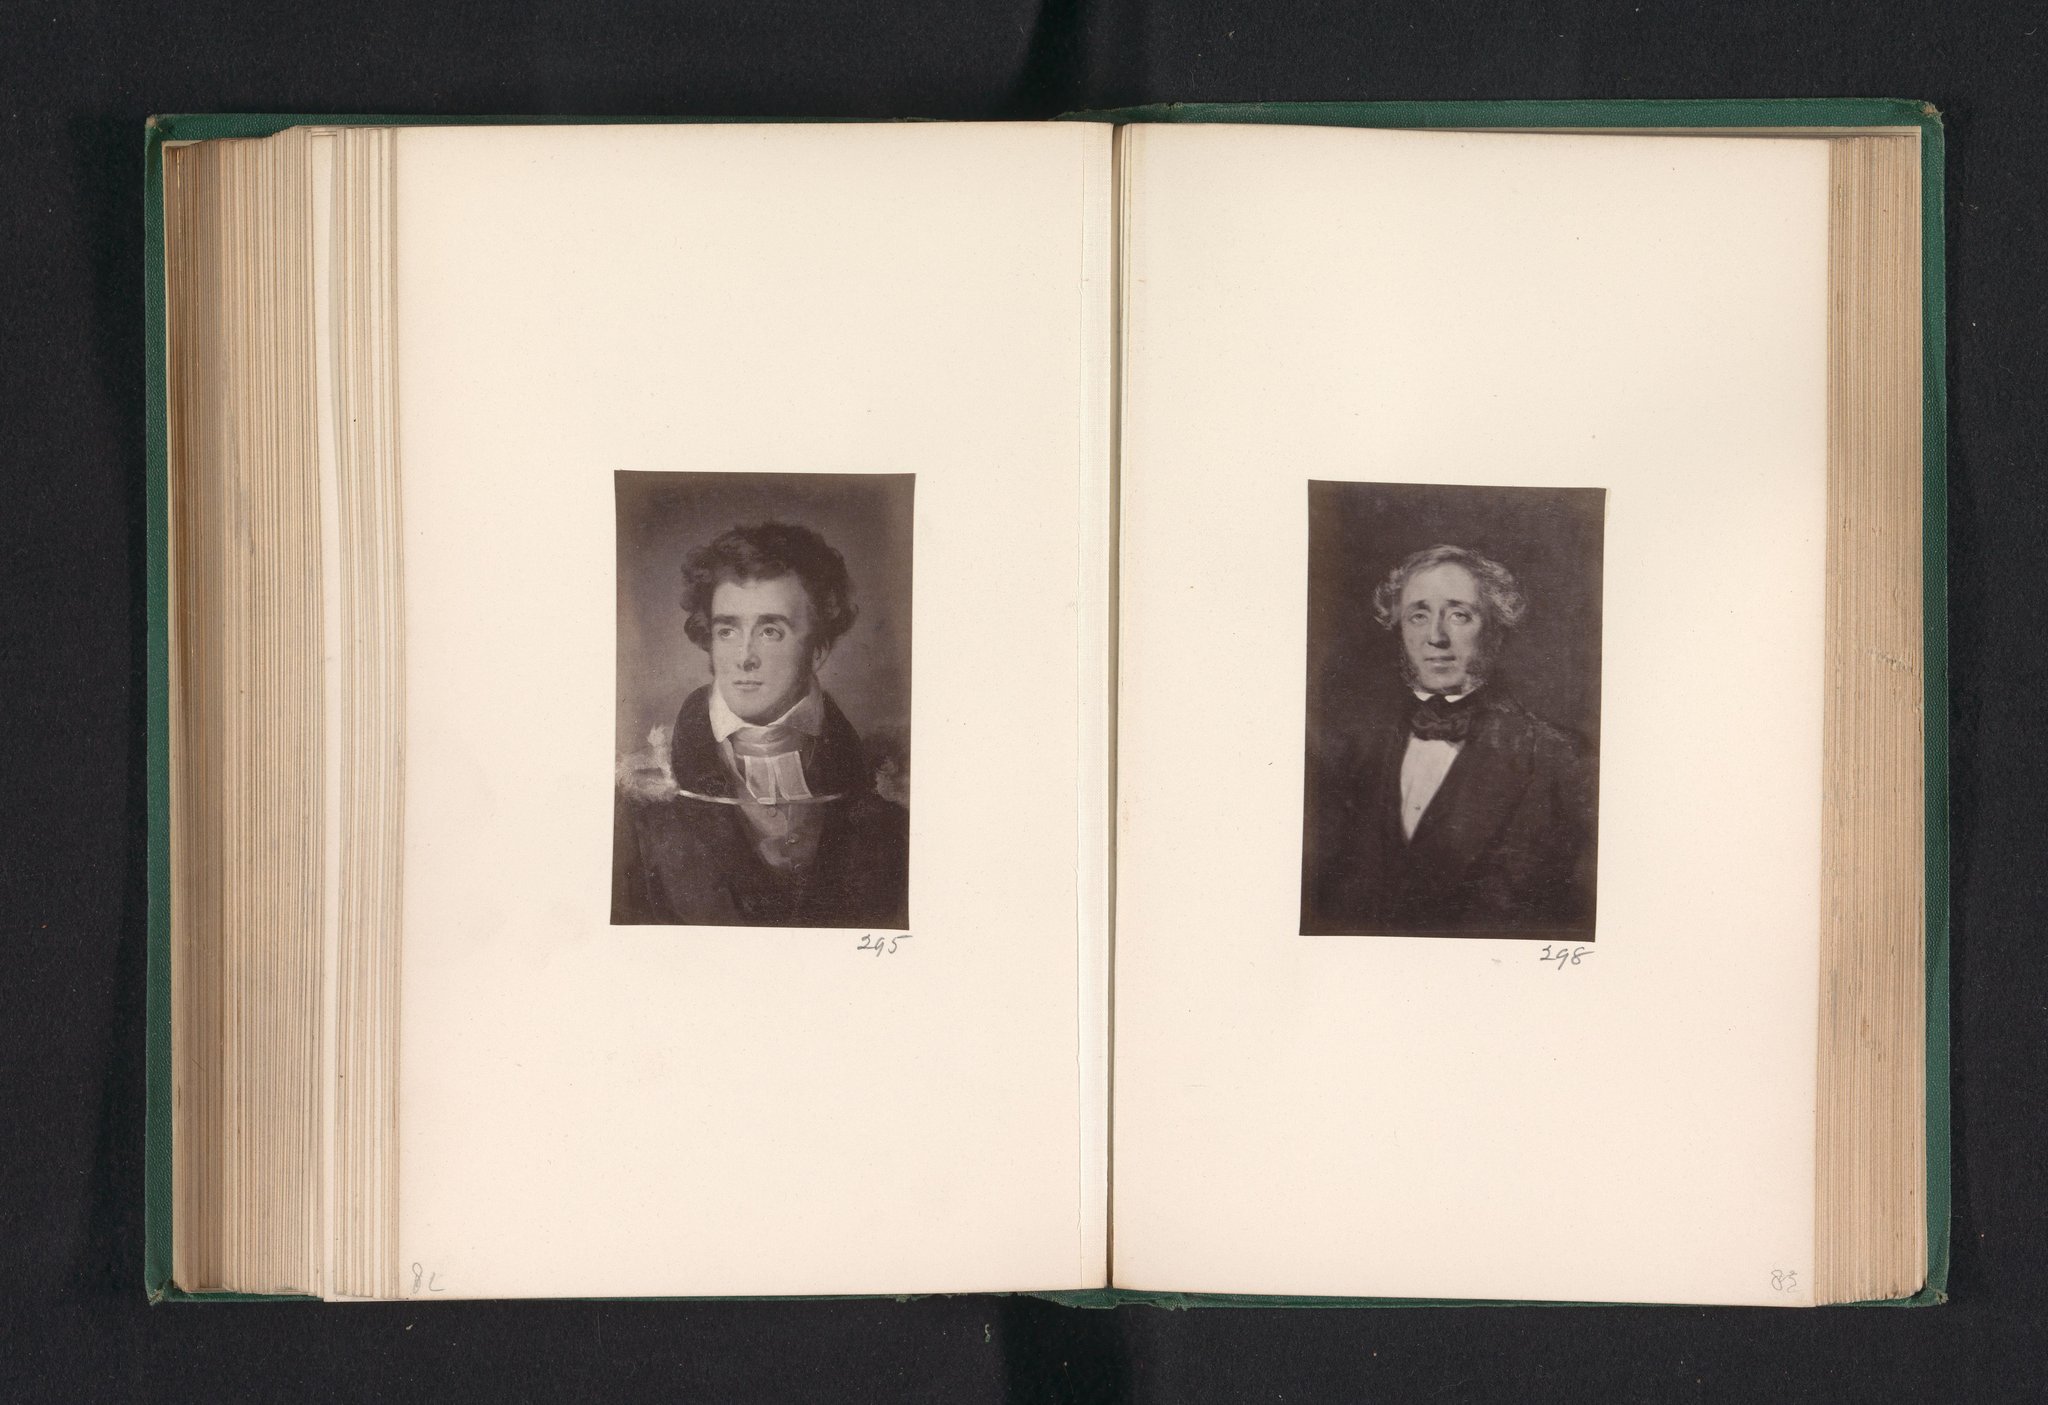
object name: page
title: Fotoreproductie van een schilderij, voorstellende een portret van William Campbell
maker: thomas annan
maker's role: fotograaf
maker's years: 1829-1887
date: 1863-1868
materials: photographic support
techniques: albumen print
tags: historical persons (portraits and scenes from the life) (+ (full) bust portrait)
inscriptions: number: ‘298’